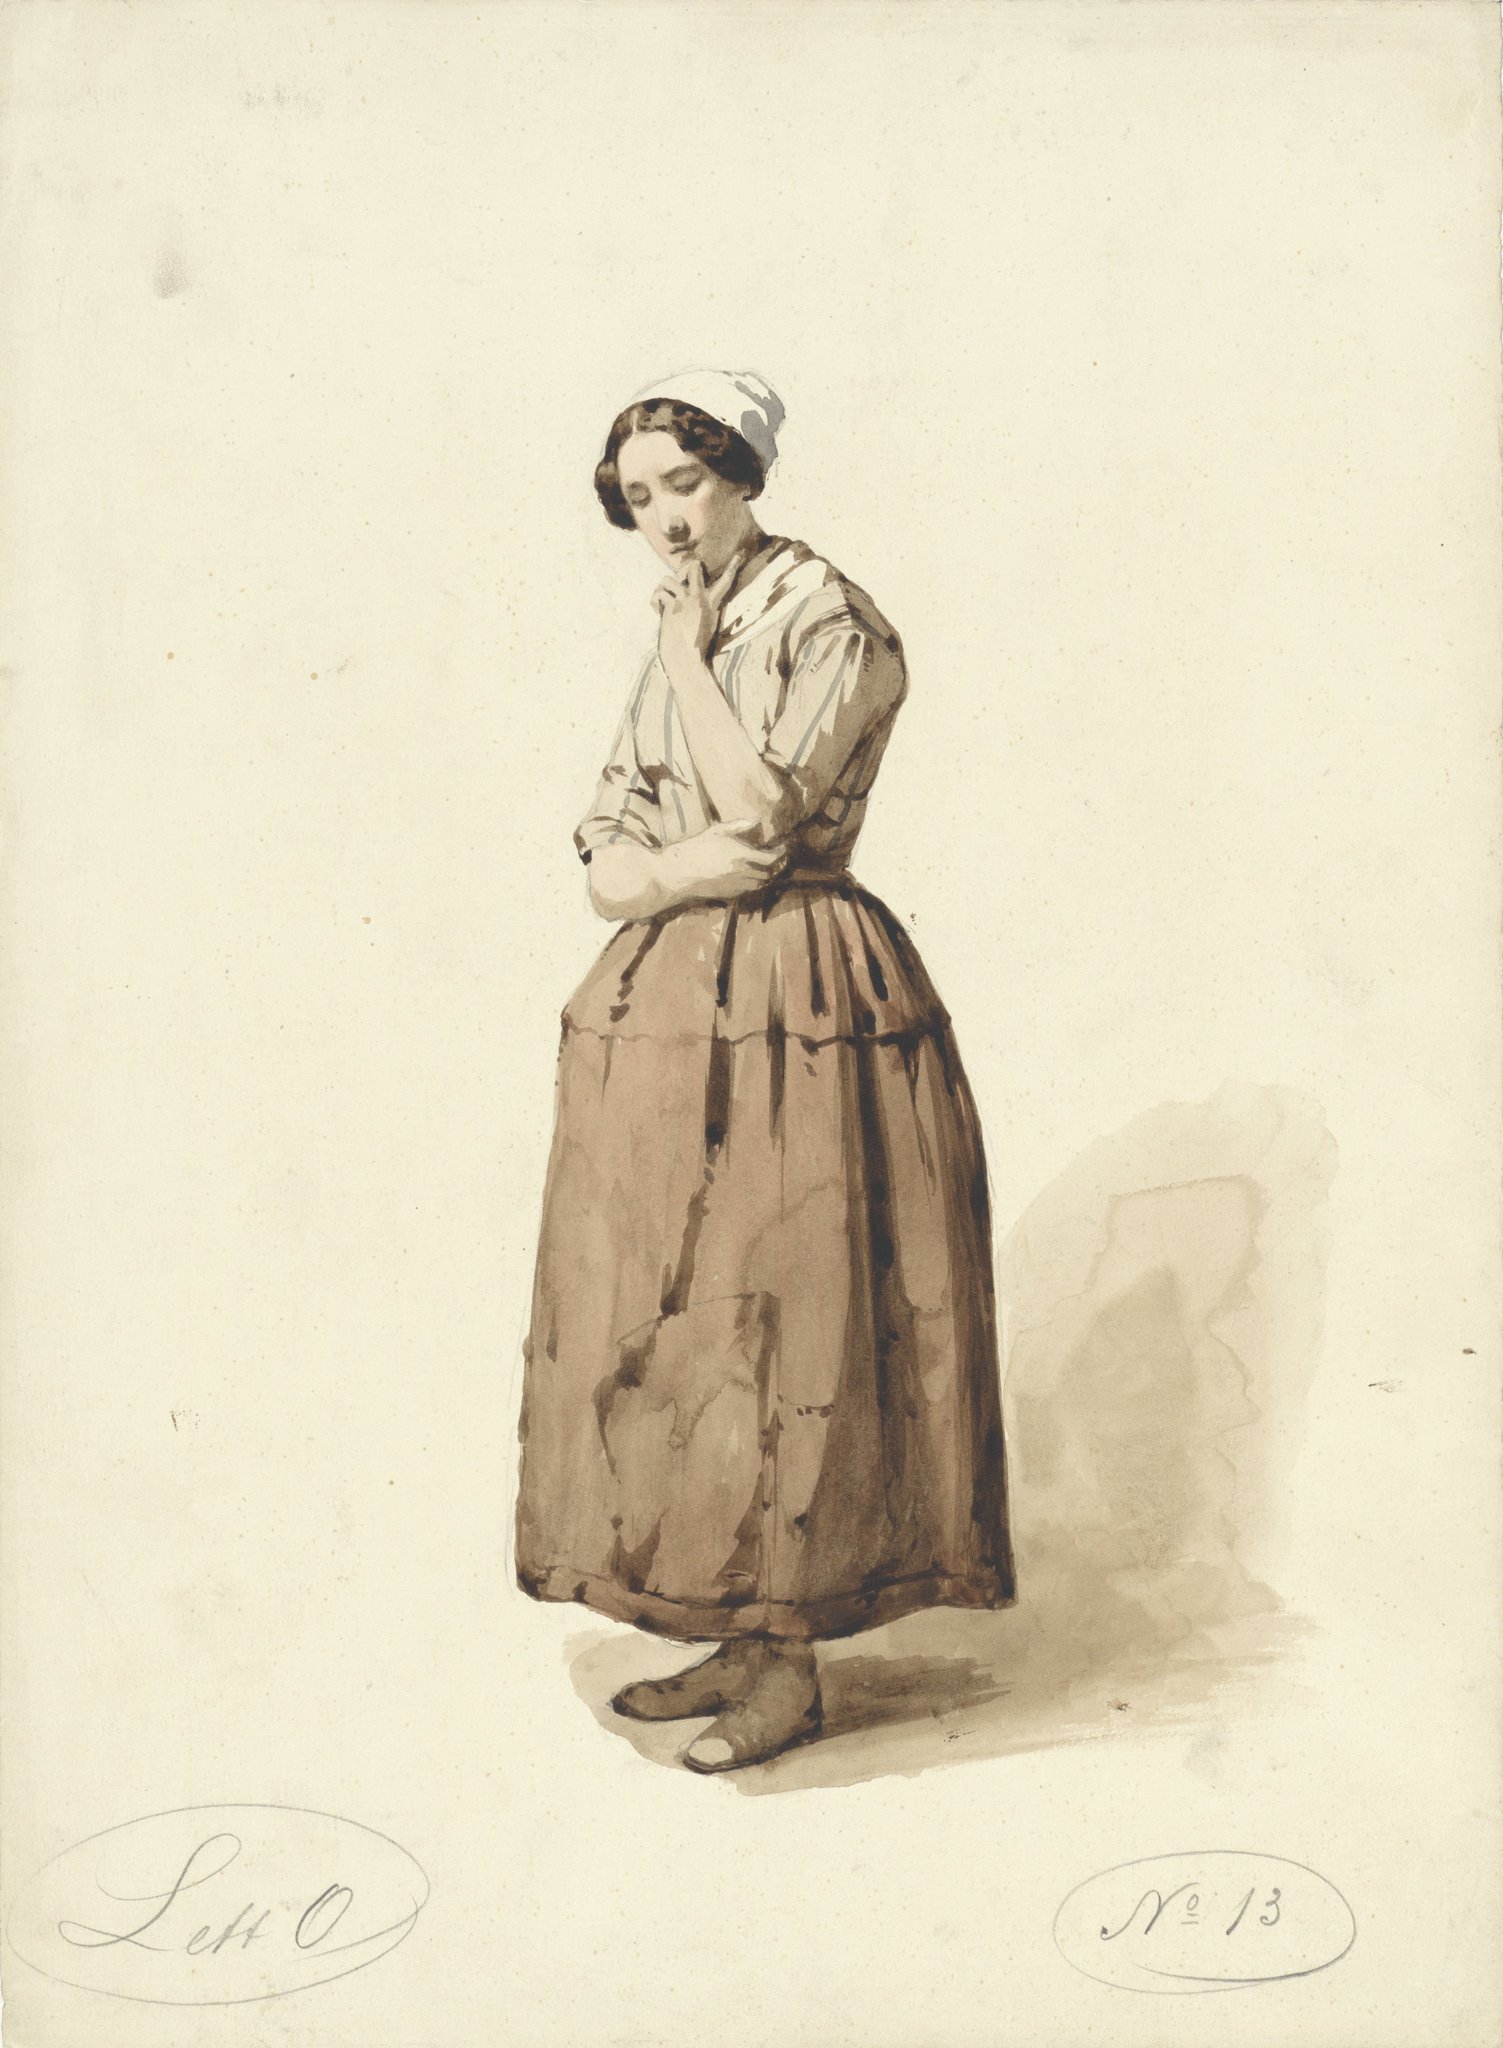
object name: drawing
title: Staande peinzende vrouw, driekwart naar links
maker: johannes engel masurel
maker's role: draughtsman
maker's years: 1826-1915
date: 1836-1915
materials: paper, pencil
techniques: brush